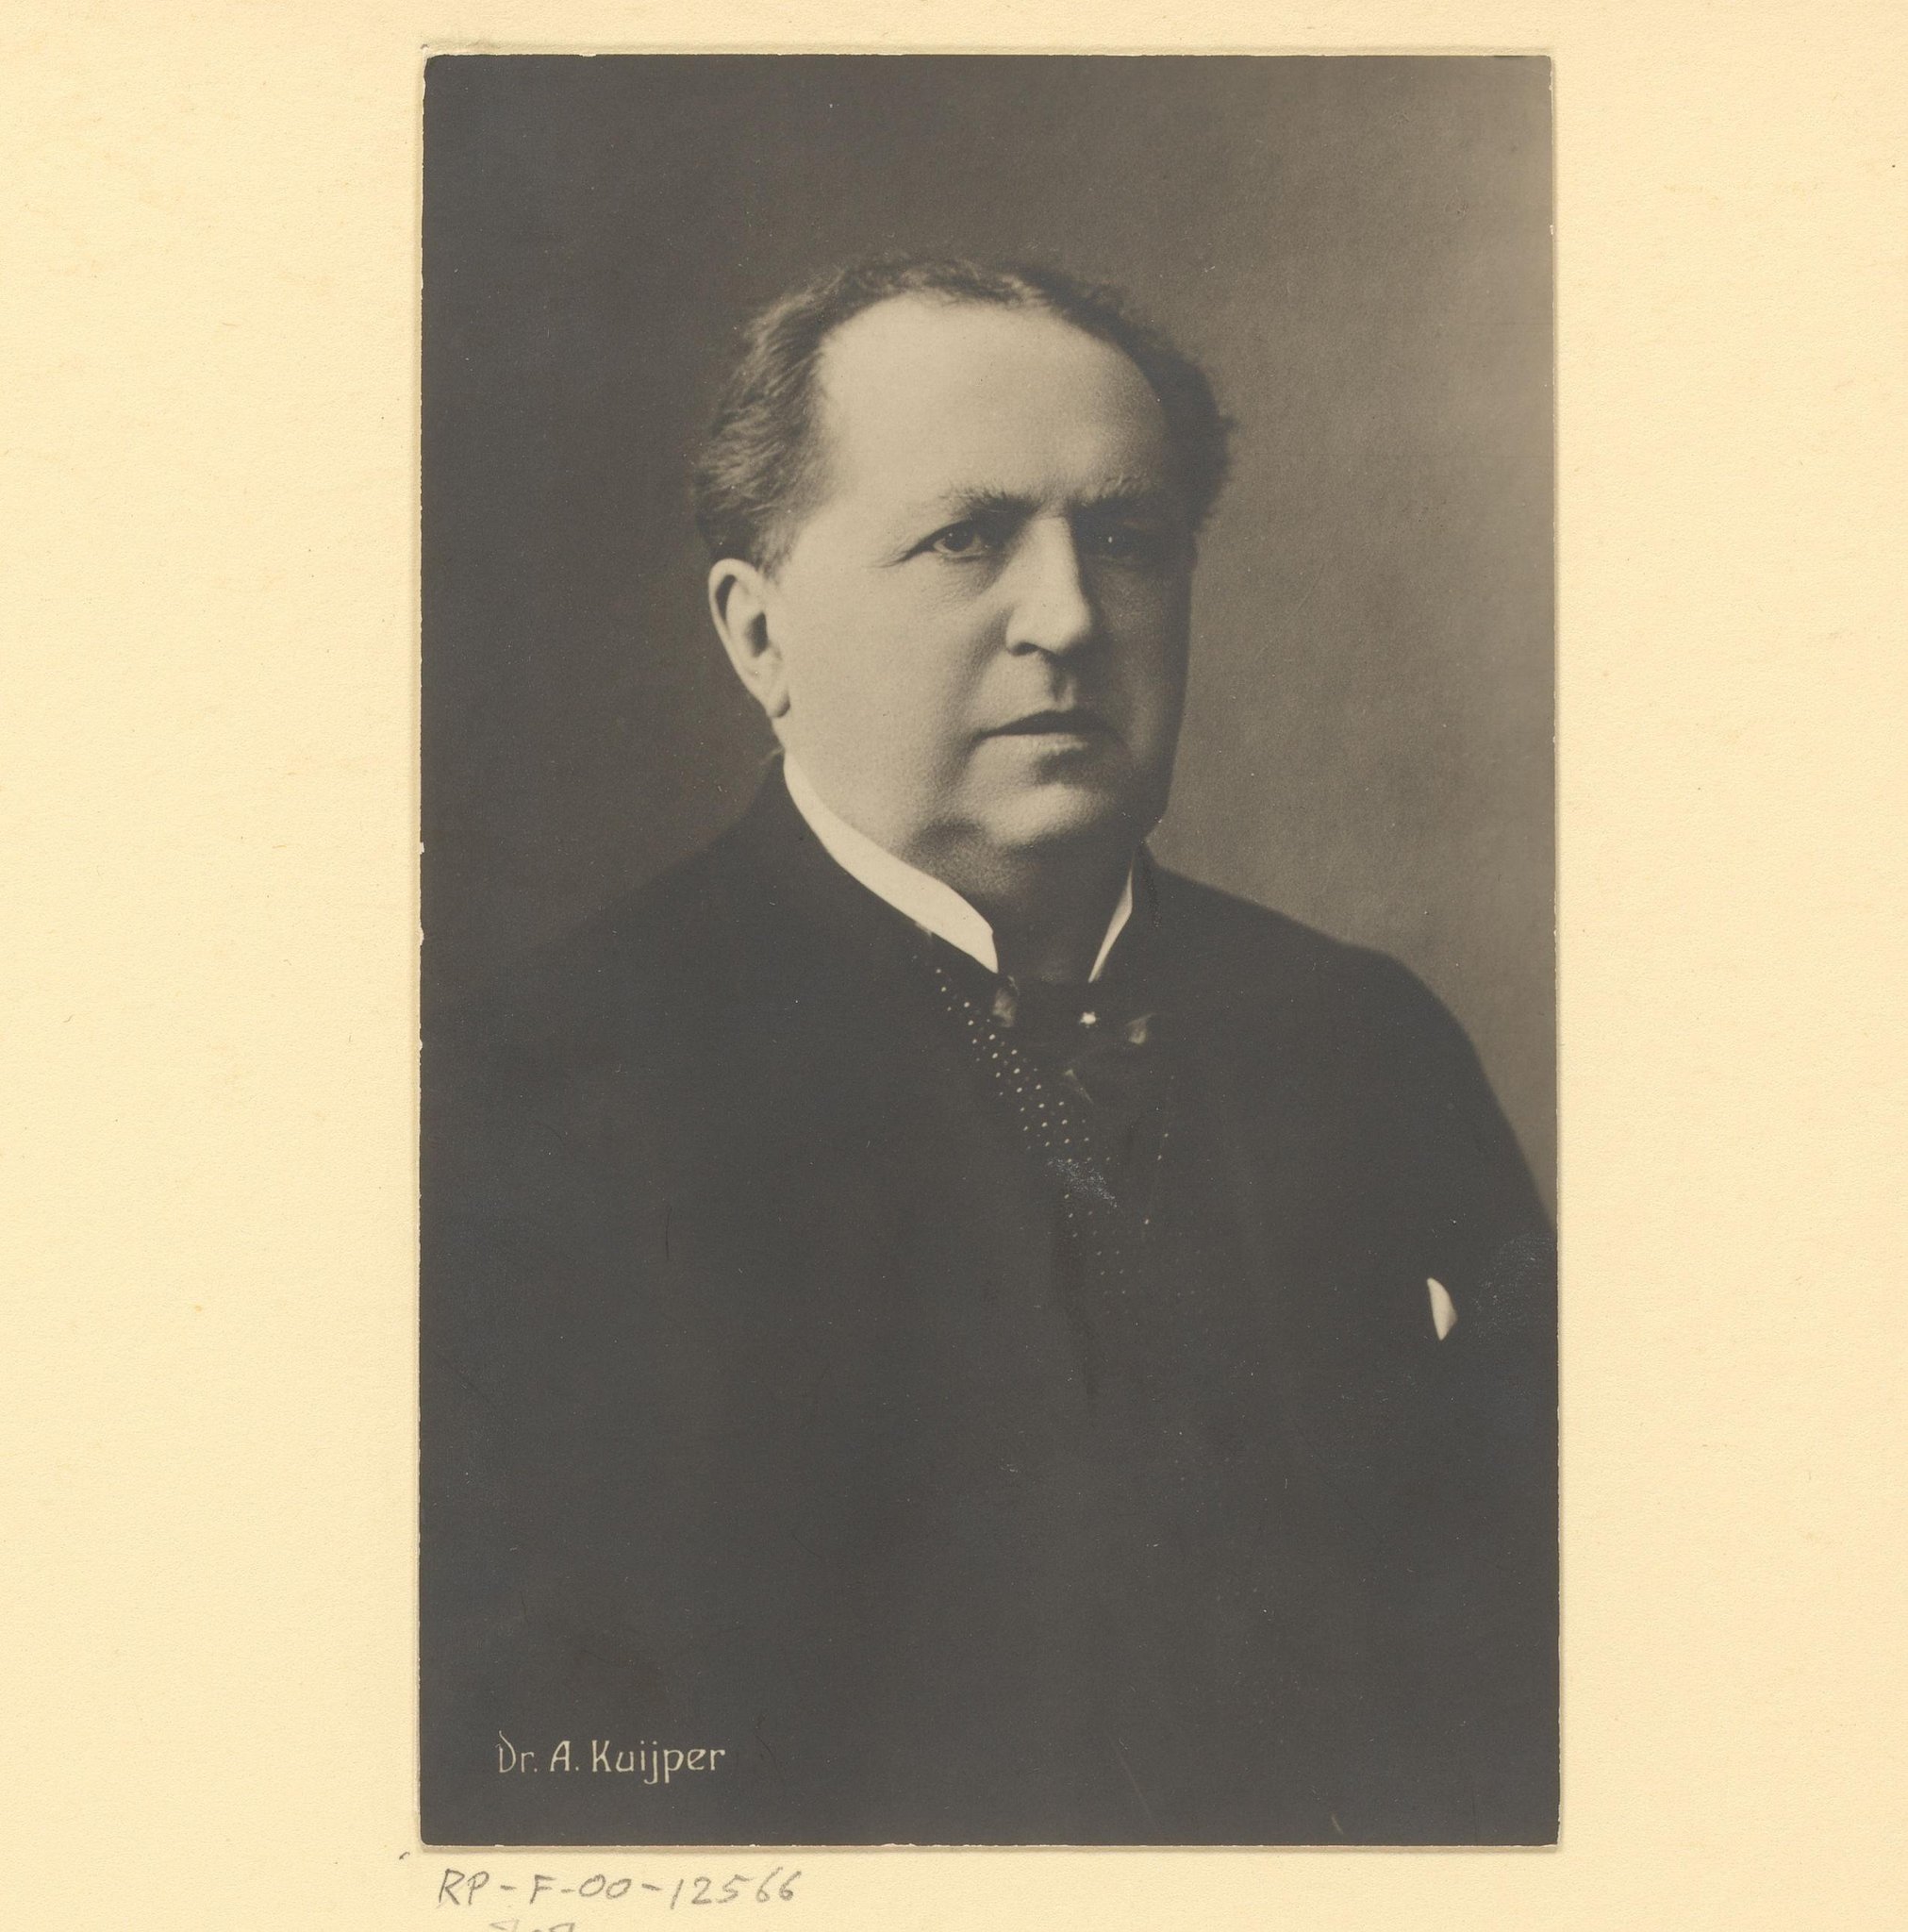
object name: photograph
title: Portret van Abraham Kuyper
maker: Anonymous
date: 1900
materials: paper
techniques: gelatin silver print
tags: the hague, abraham kuyper, historical persons